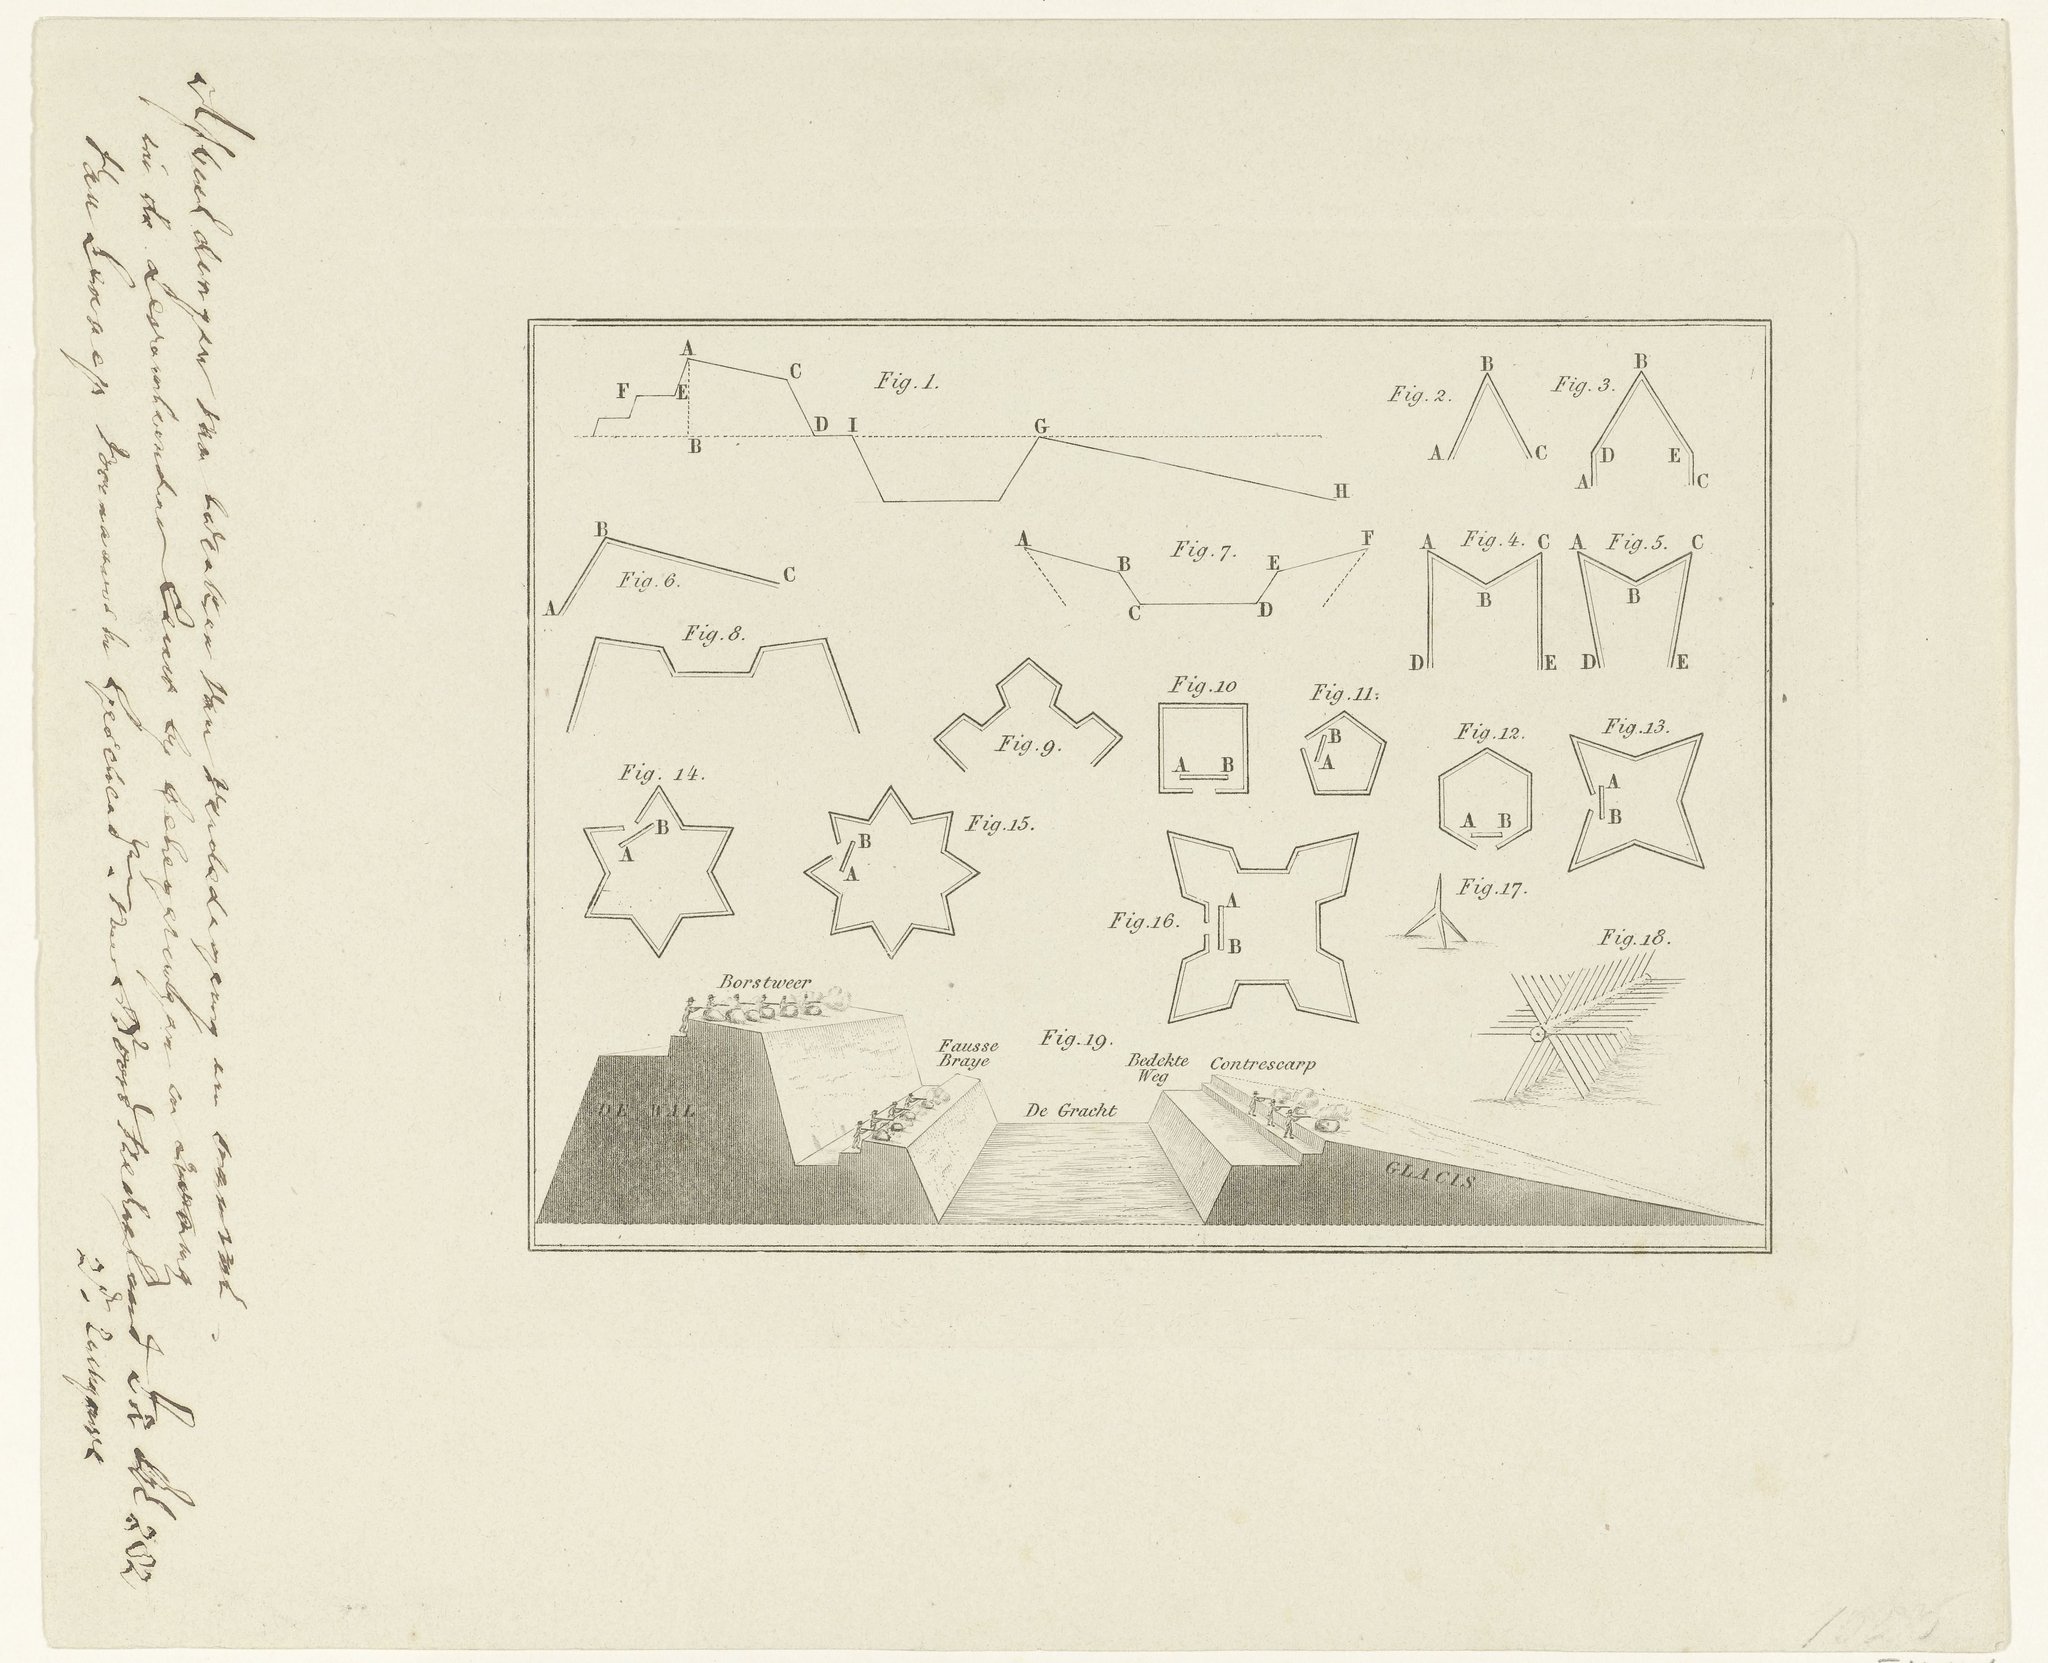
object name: print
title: Verdedigings- en aanvalswerken in gebruik in de zeventiende eeuw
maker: Anonymous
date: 1843-1849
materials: paper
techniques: etching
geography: netherlands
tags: the hague, frederick henry (prince of orange), fortifications, military engineering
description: Verdedigings- en aanvalswerken in gebruik in de zeventiende eeuw, bijvoorbeeld bij het beleg van Den Bosch door het Staatse leger onder Frederik Hendrik, van 1 mei tot 17 september 1629. Verschillende figuren genummerd 1-19.